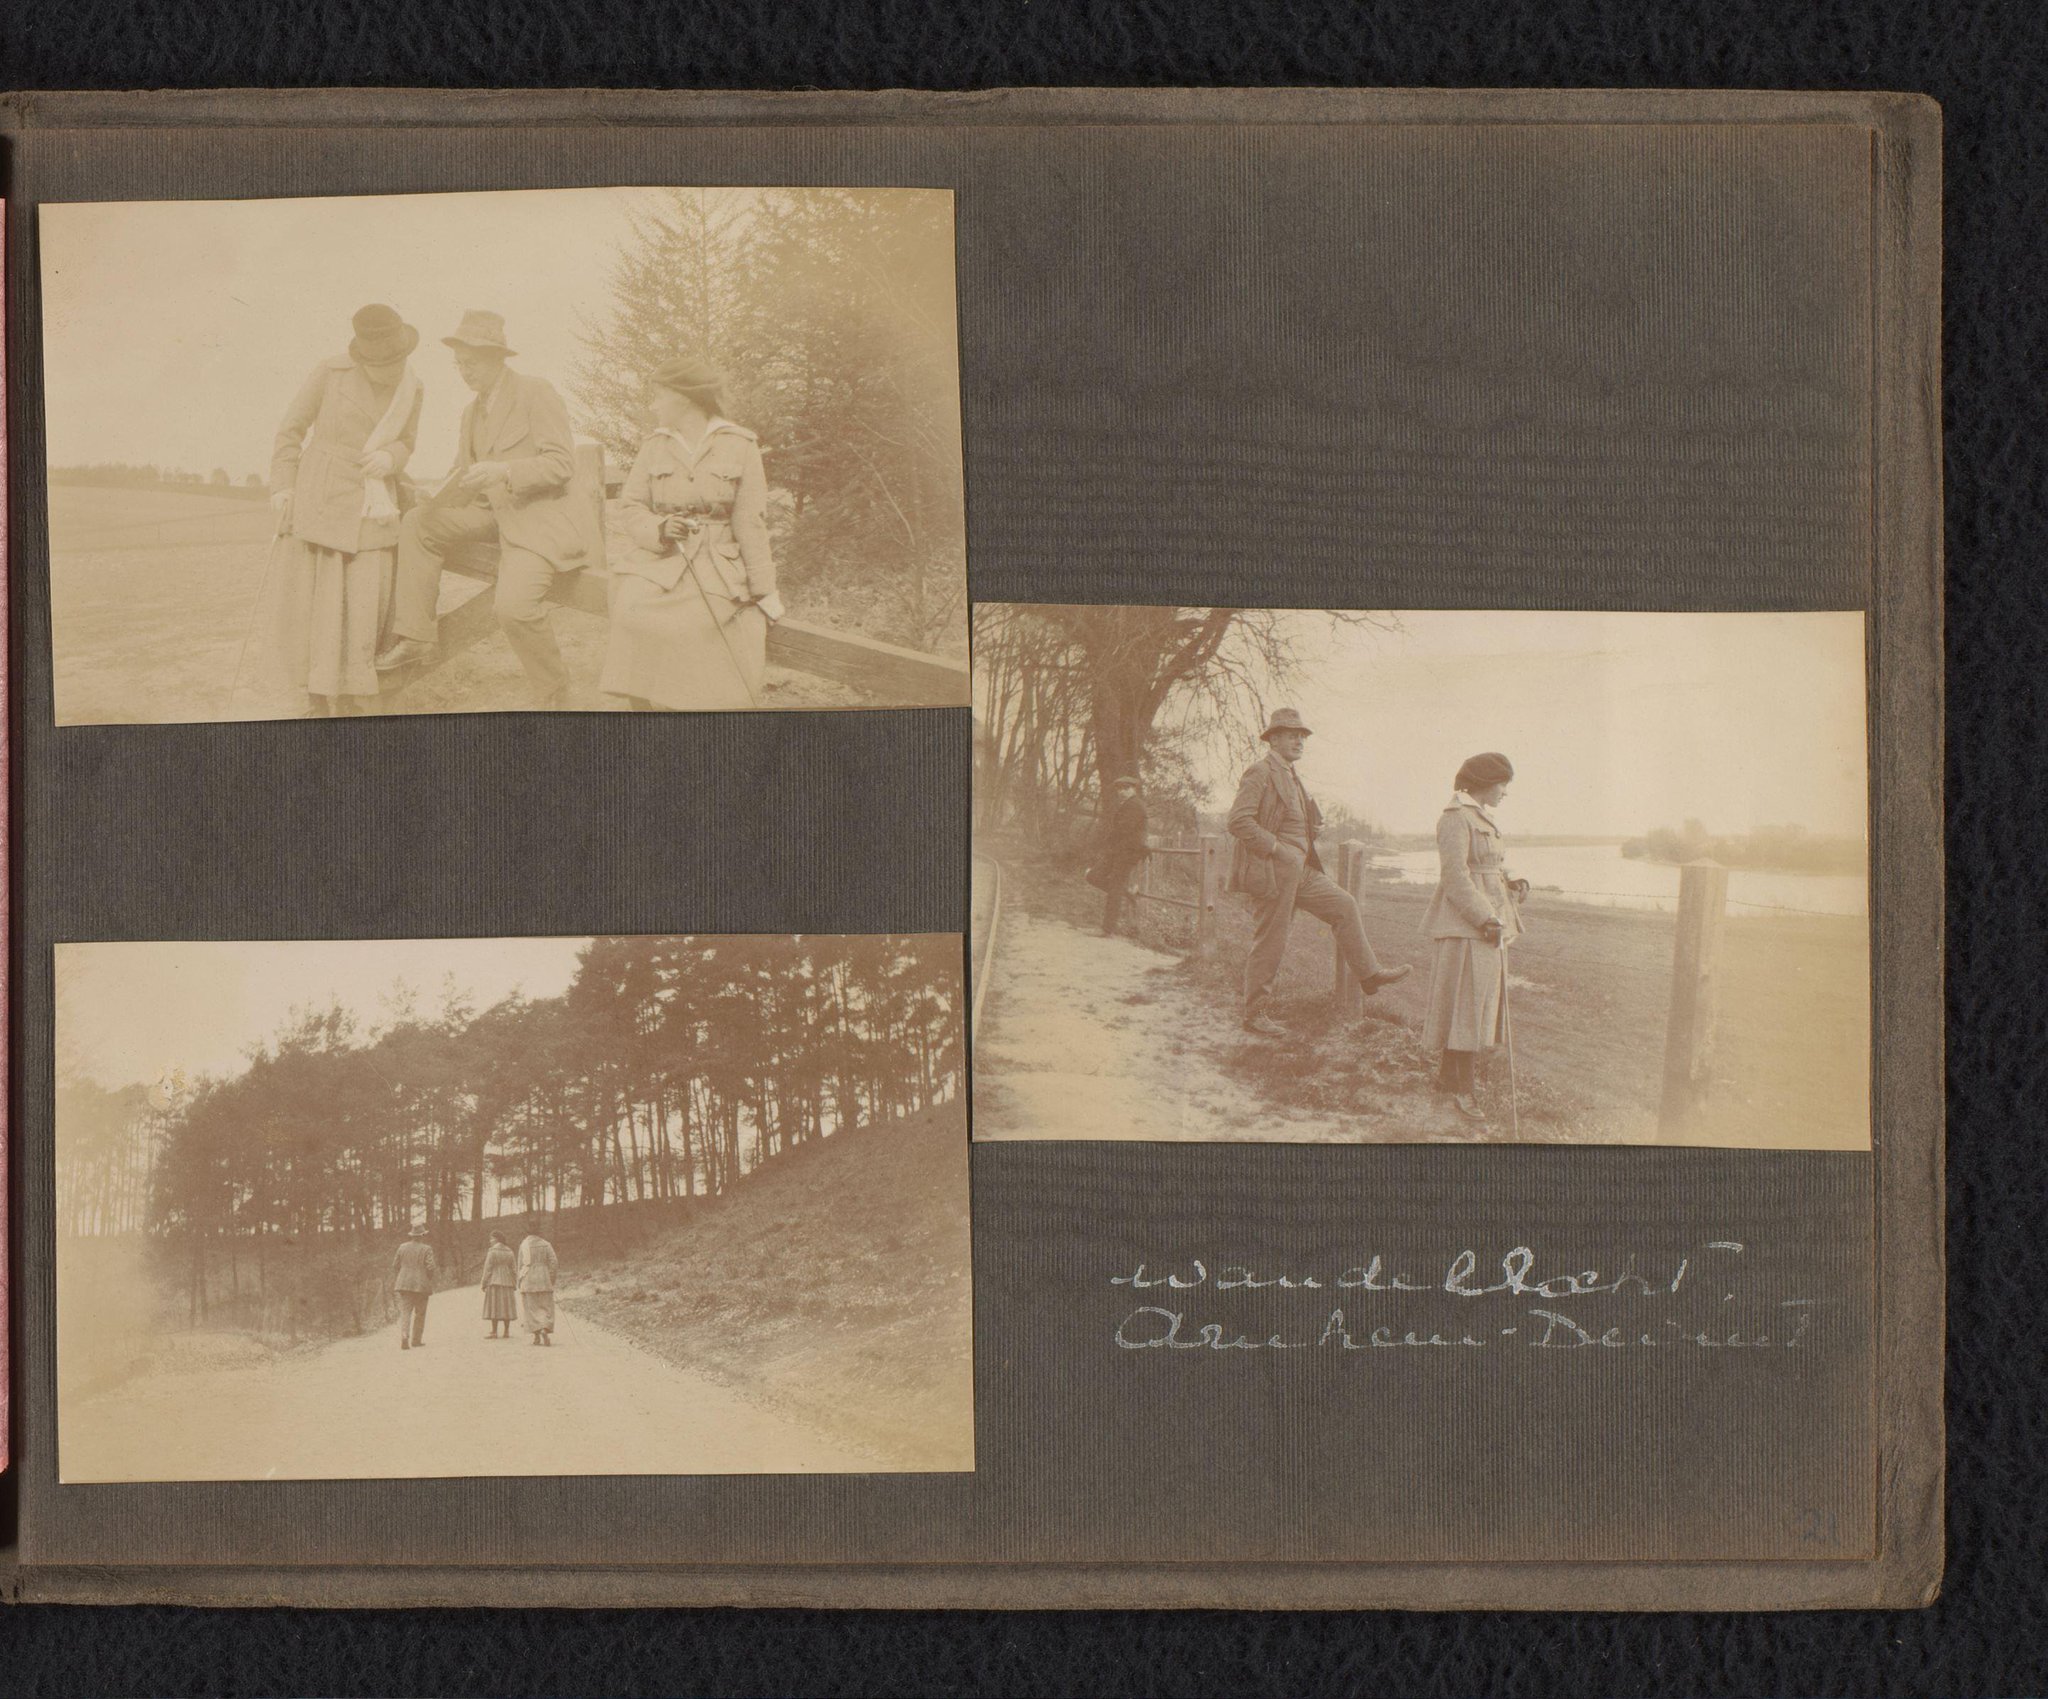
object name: album leaf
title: Drie foto's van leden van familie Onnen-Van den Berg tijdens een wandeling tussen Arnhem en Deventer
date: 1918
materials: paper, cardboard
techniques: gelatin silver print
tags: walking, hiking (recreation), historical persons, fringe, edge of the wood, deventer, arnhem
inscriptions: caption: ‘wandeltocht./ Arnhem-Deventer’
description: Deze foto's maken deel uit van een album.